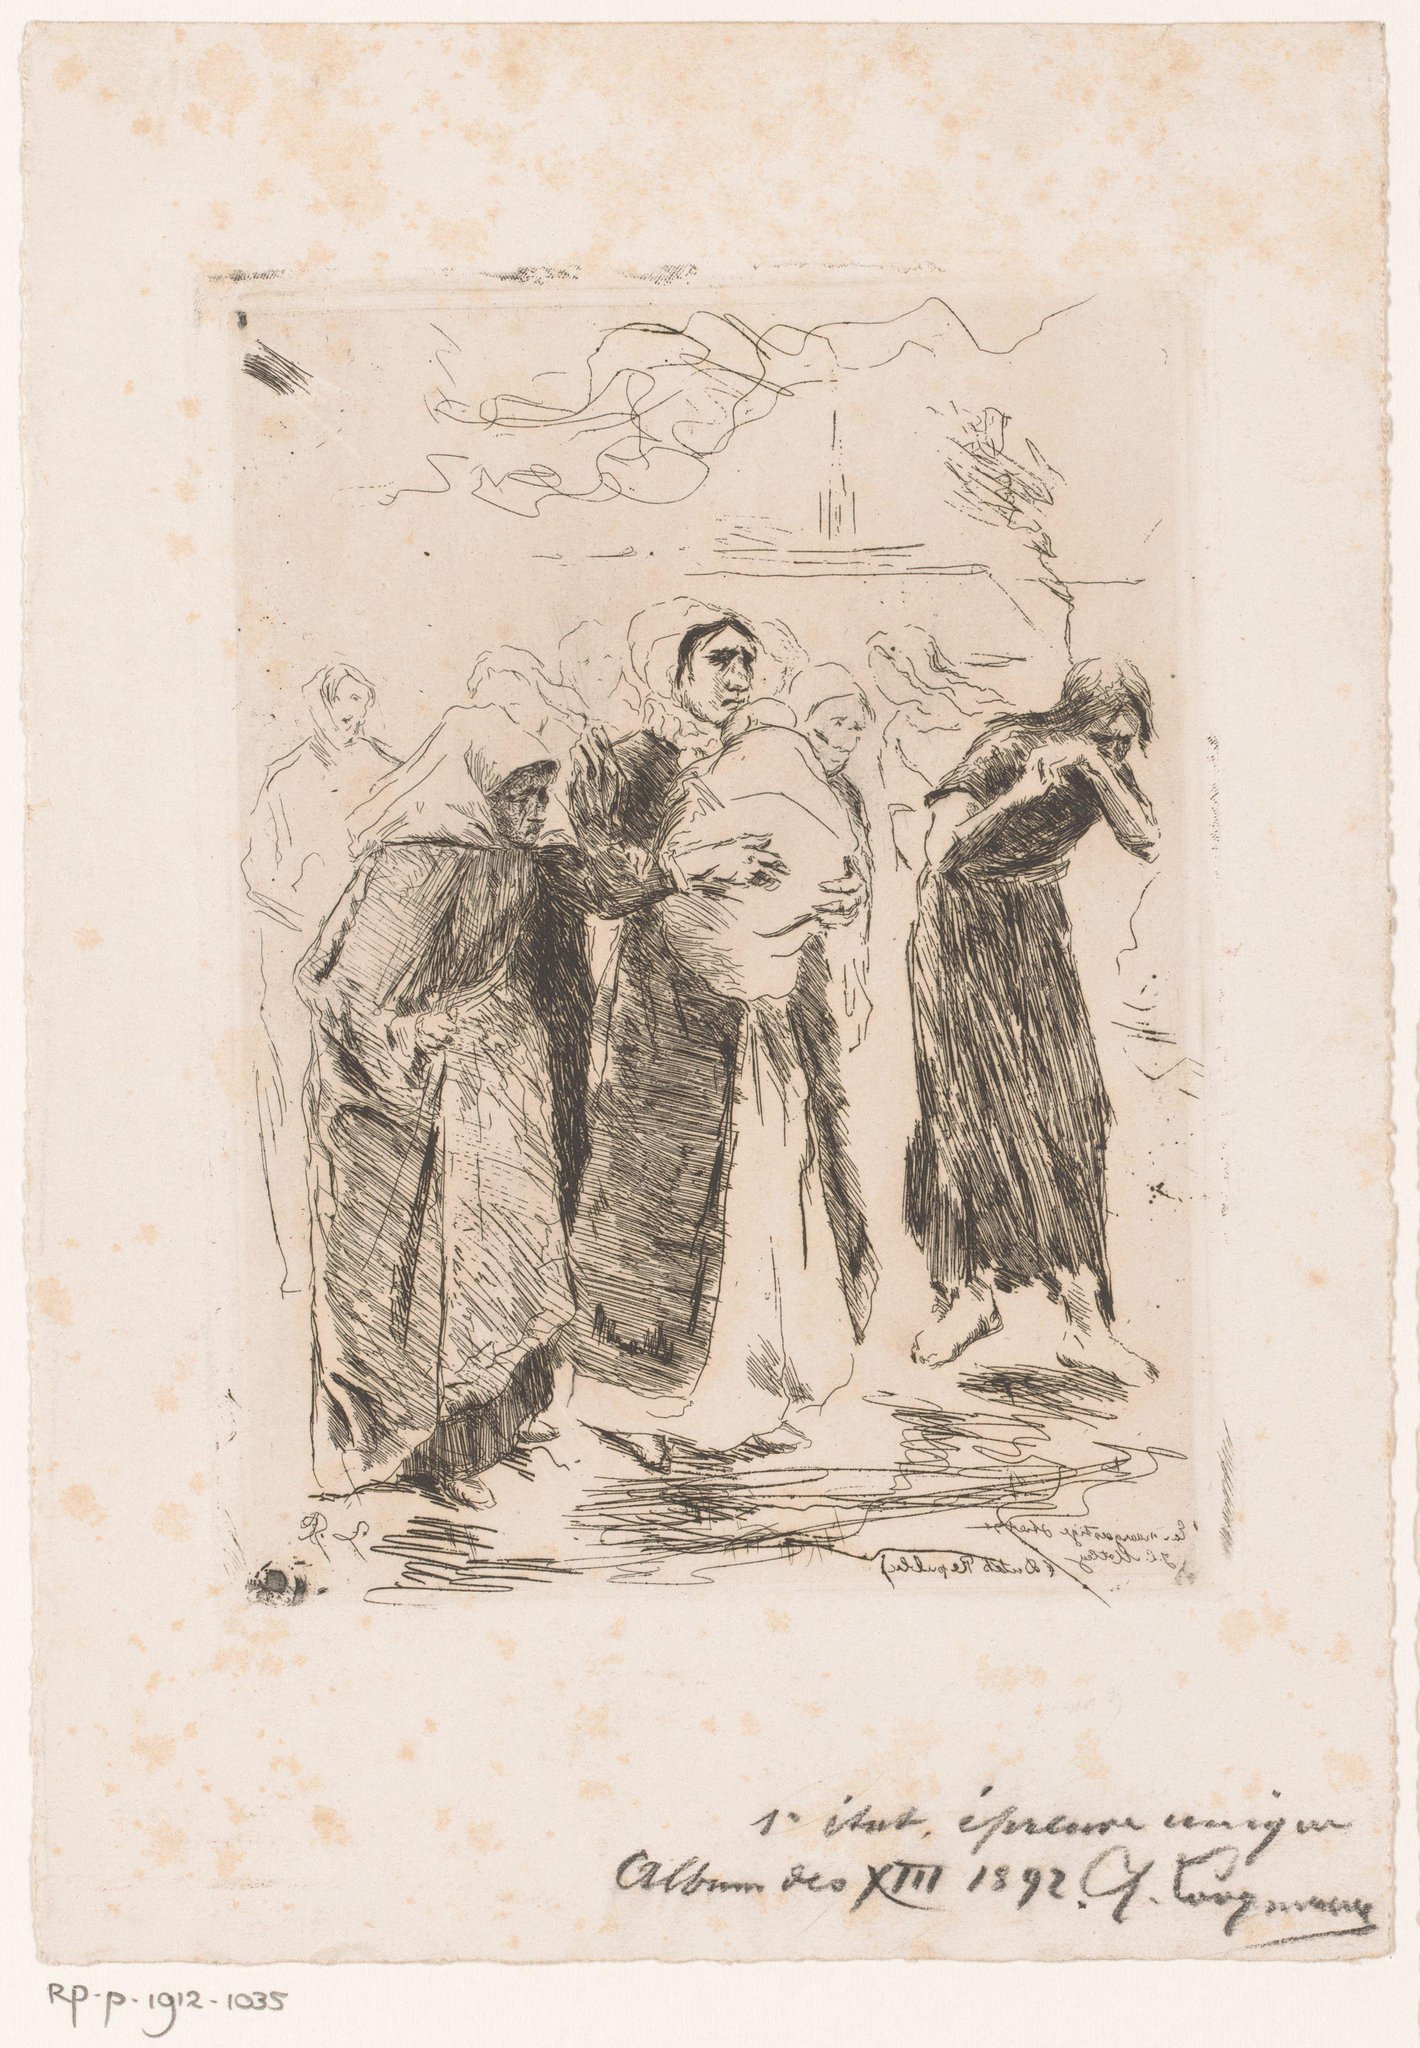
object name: print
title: Stoet vluchtelingen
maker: romain looymans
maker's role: print maker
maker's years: 1864-1914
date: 1892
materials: paper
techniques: etching, intaglio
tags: political refugee, 'émigré'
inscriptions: annotation: ‘1e état, épreuve unique/ Album des XIII 1892’, collector's mark: Lugt 2228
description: Latere staat van deze prent in de suite XIII, 1892. Dit was een periodieke uitgave van de kunstenaarskring Cercle des XIII.